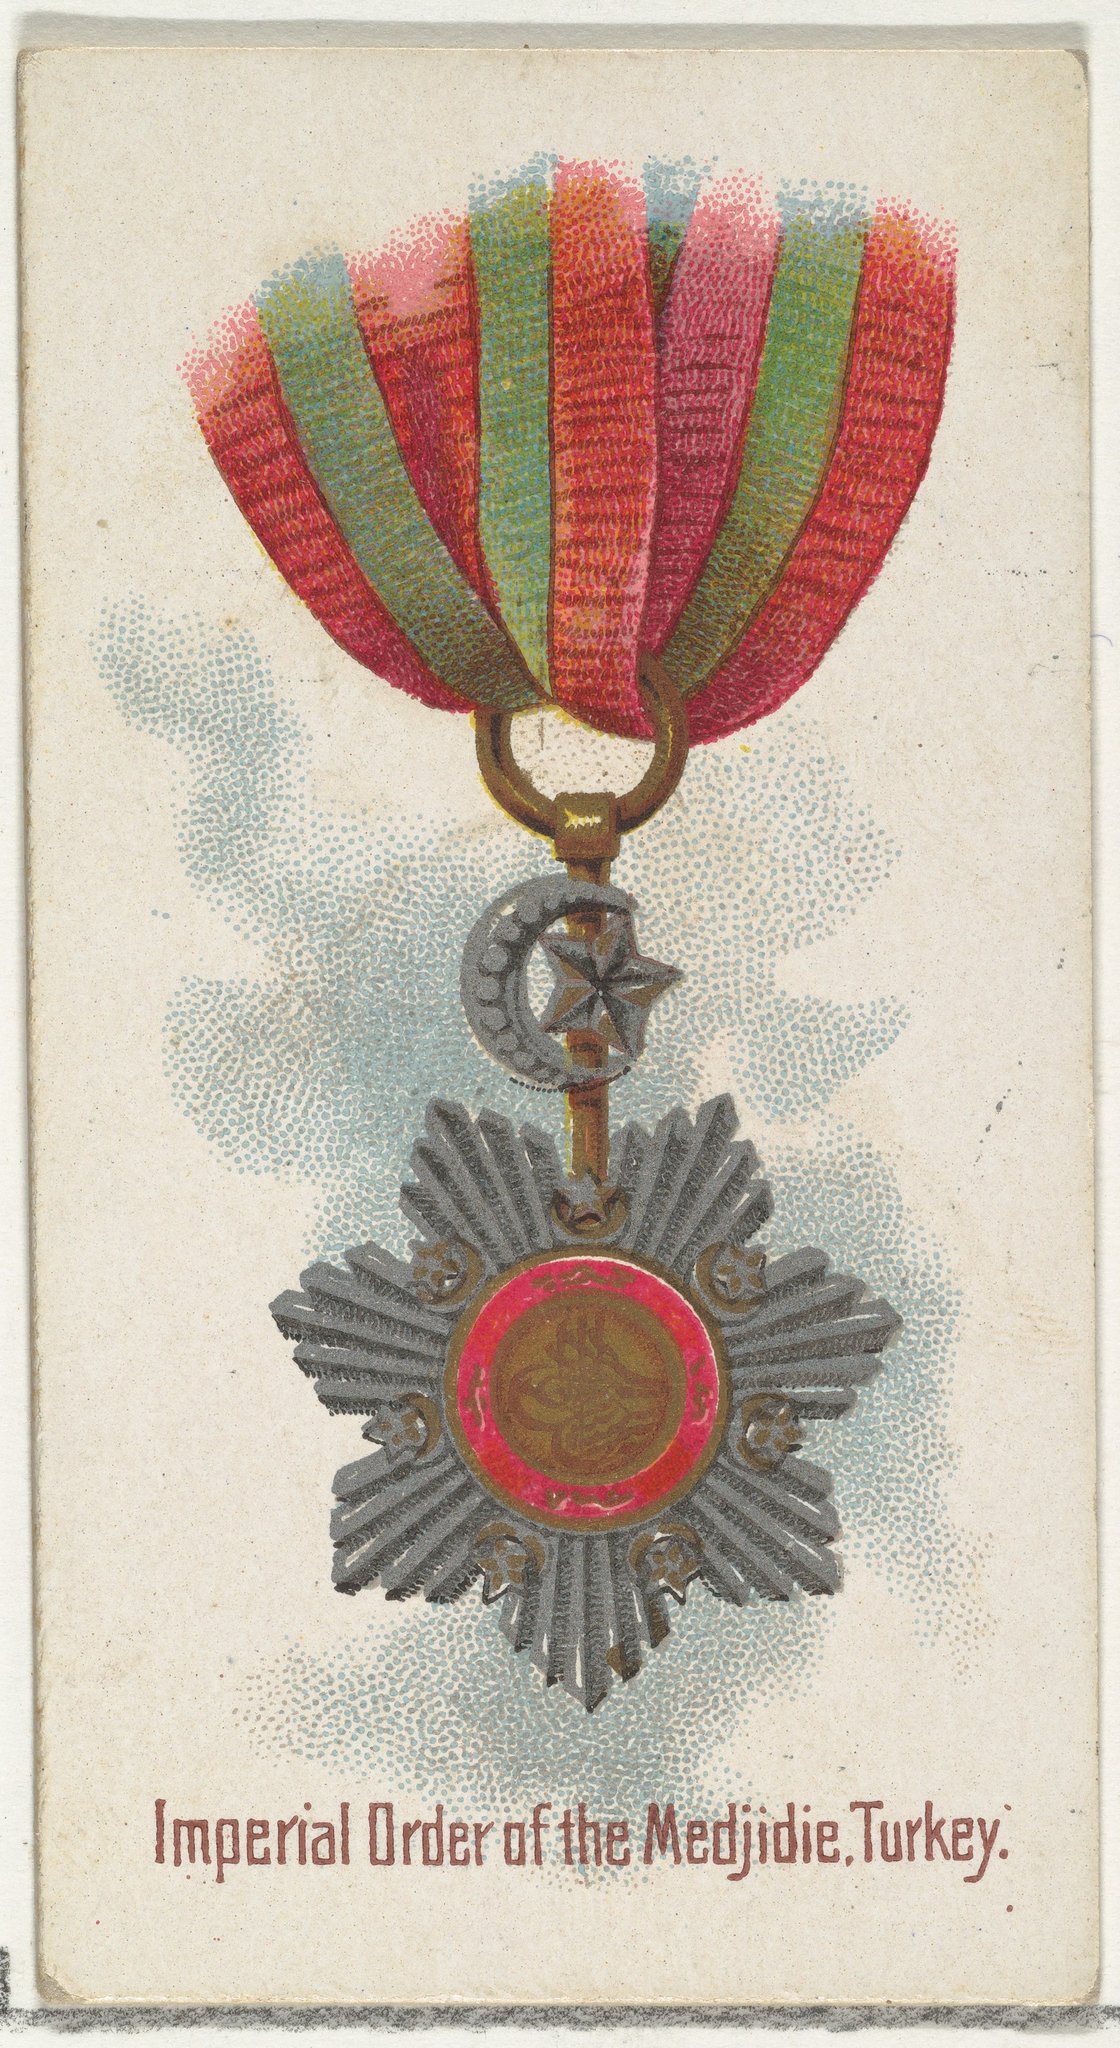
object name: print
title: Imperial Order of the Medjidie, Turkey, from the World's Decorations series (N30) for Allen & Ginter Cigarettes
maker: allen & ginter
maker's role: publisher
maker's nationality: american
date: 1890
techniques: color lithograph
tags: medals